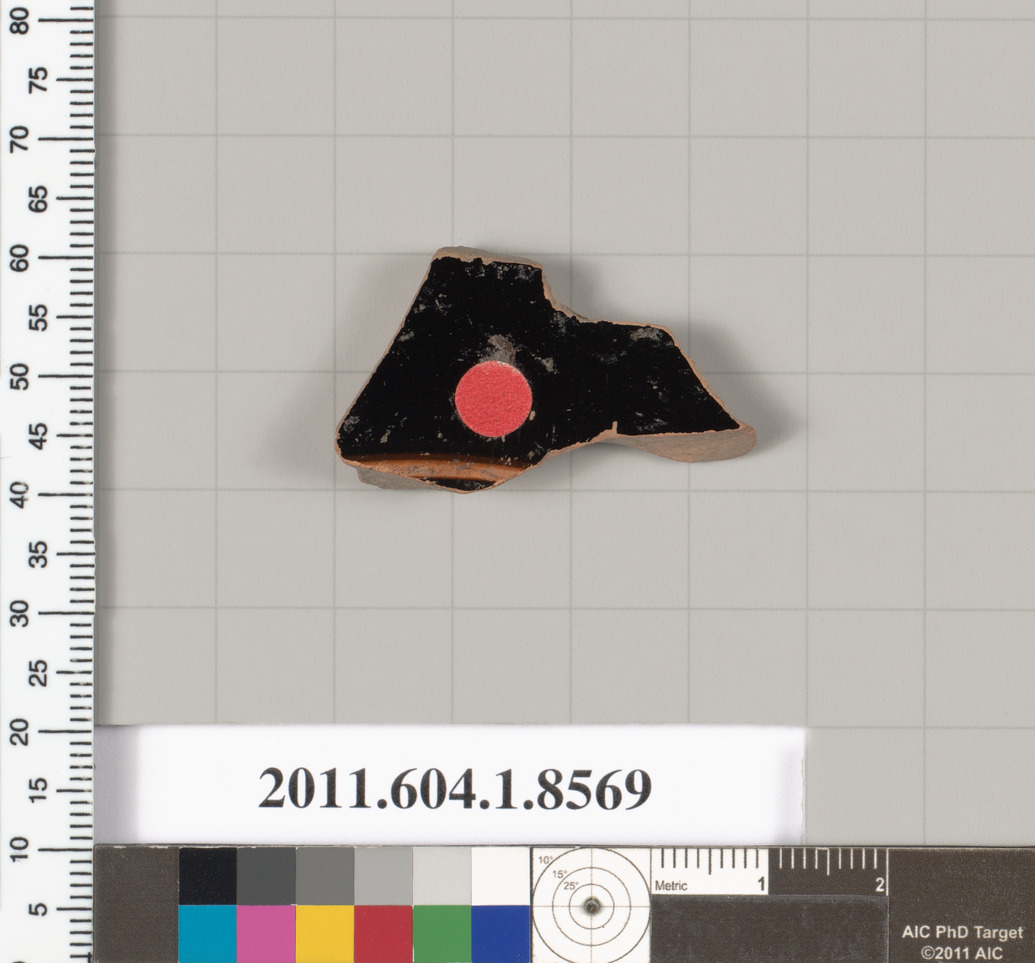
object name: kylix fragment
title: Terracotta fragment of a stemless kylix (drinking cup)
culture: greek, attic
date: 470-450 BCE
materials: terracotta